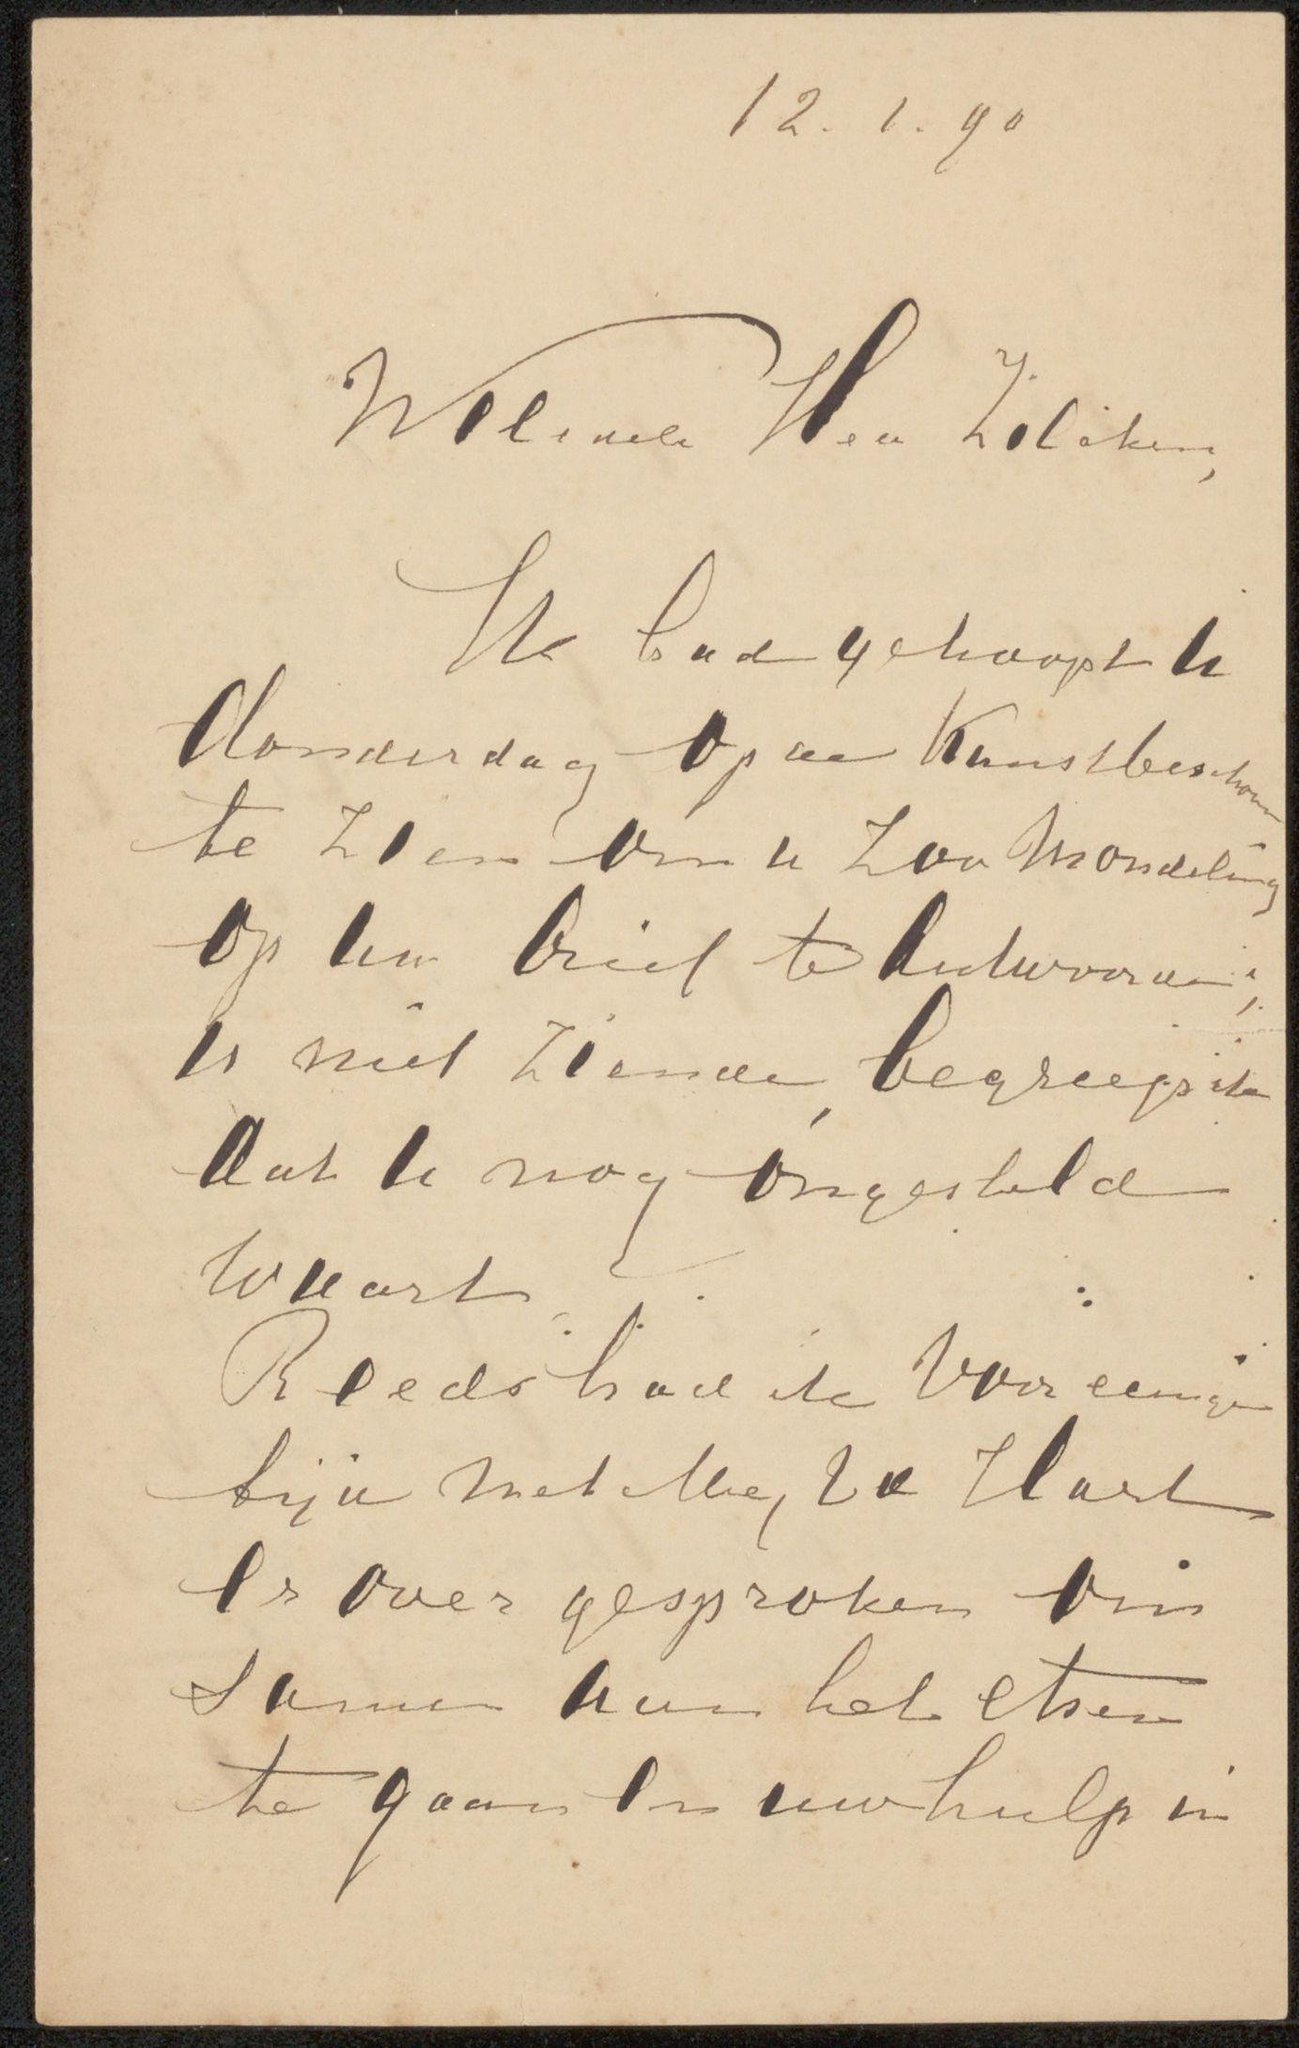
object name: letter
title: Brief aan Philip Zilcken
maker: suze robertson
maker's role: draughtsman, painter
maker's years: 1855-1922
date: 1890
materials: ink, paper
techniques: pen, writing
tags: the hague, print maker, cornelia van der hart, philip zilcken, the graphic arts, education, tuition of the artist (in general), diseases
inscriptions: collector's mark: ‘RPK’